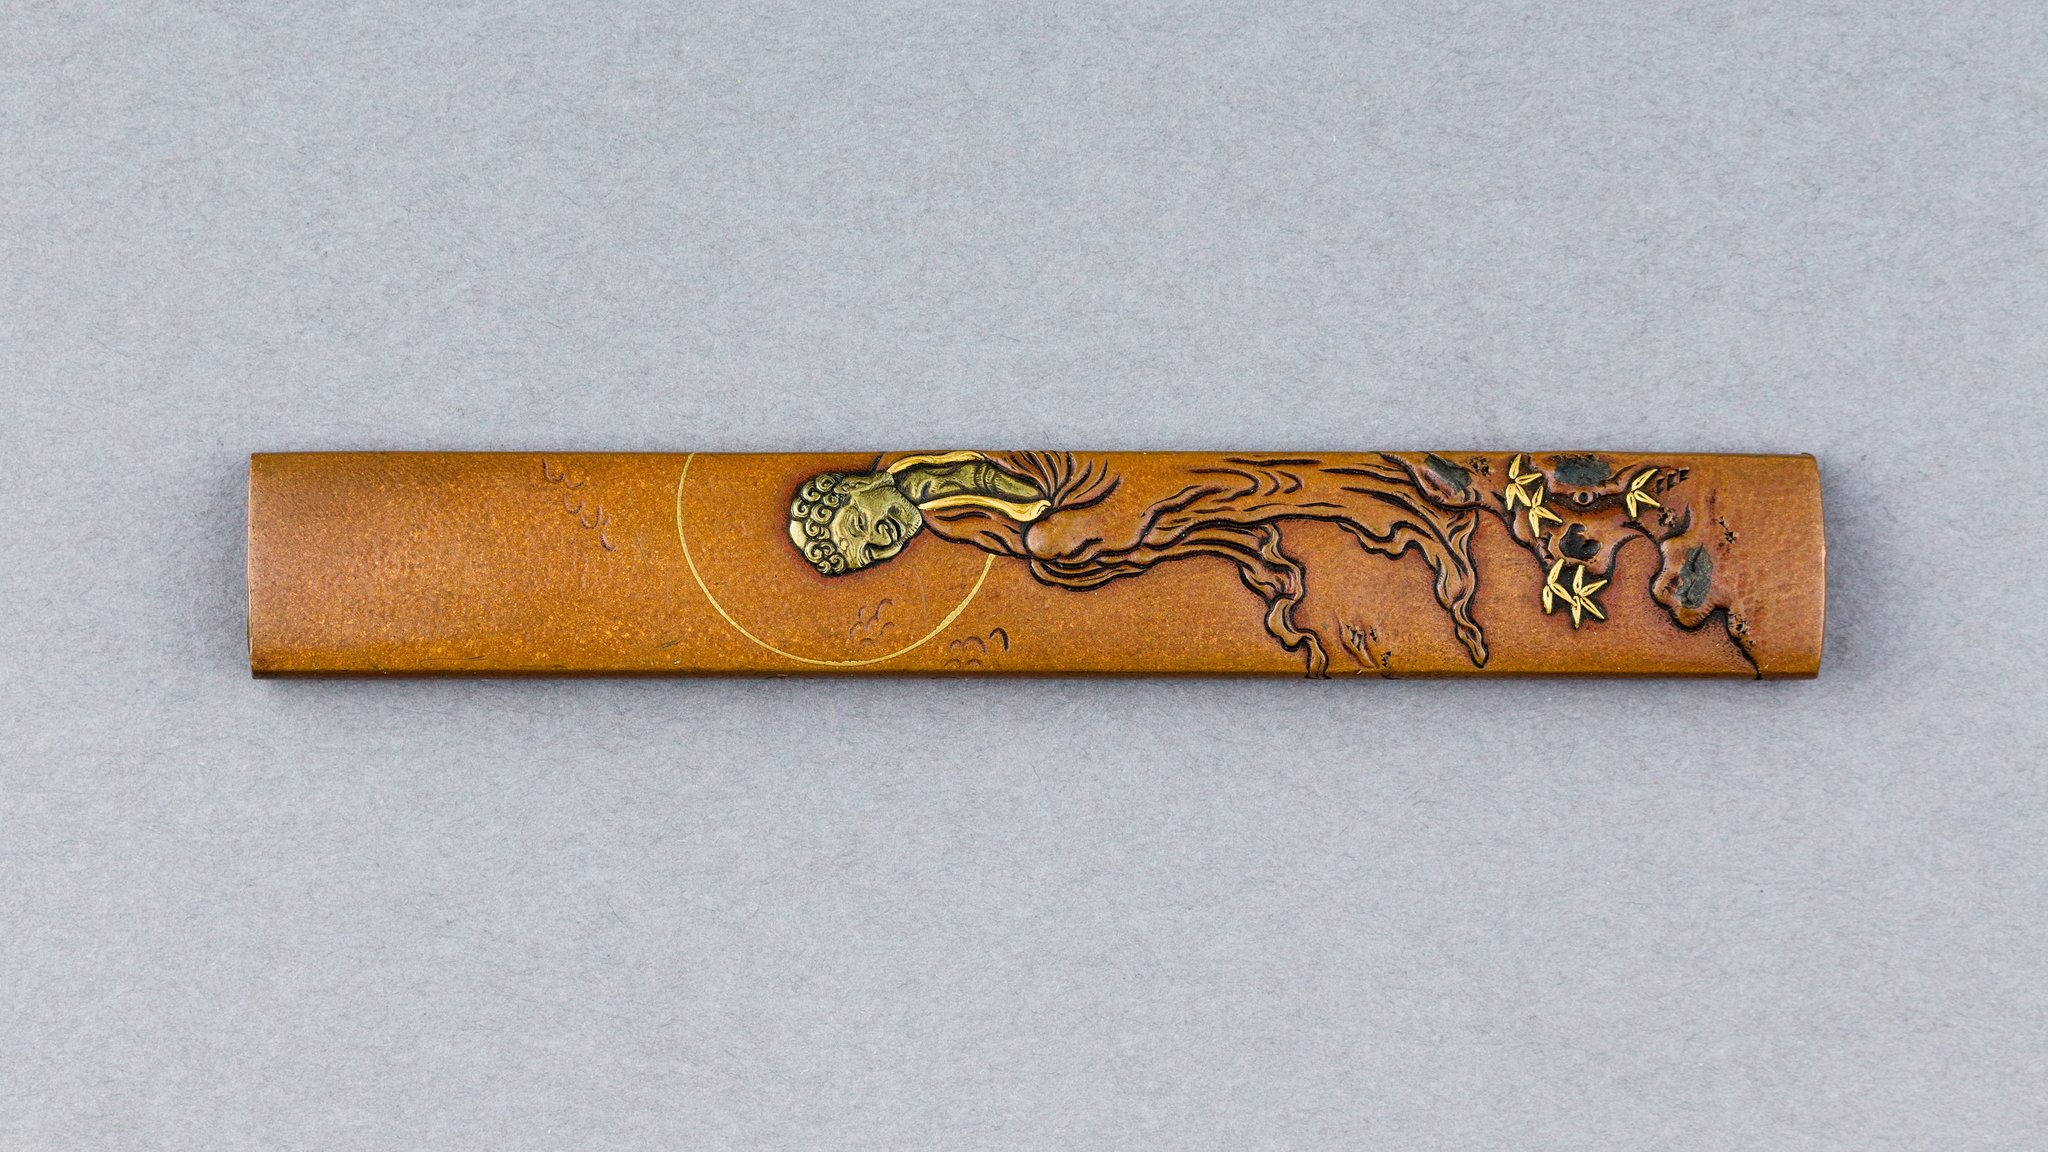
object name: knife handle kozuka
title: Knife Handle (Kozuka)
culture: japanese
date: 1615-1868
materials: copper, copper alloy, gold, silver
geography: japan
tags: men